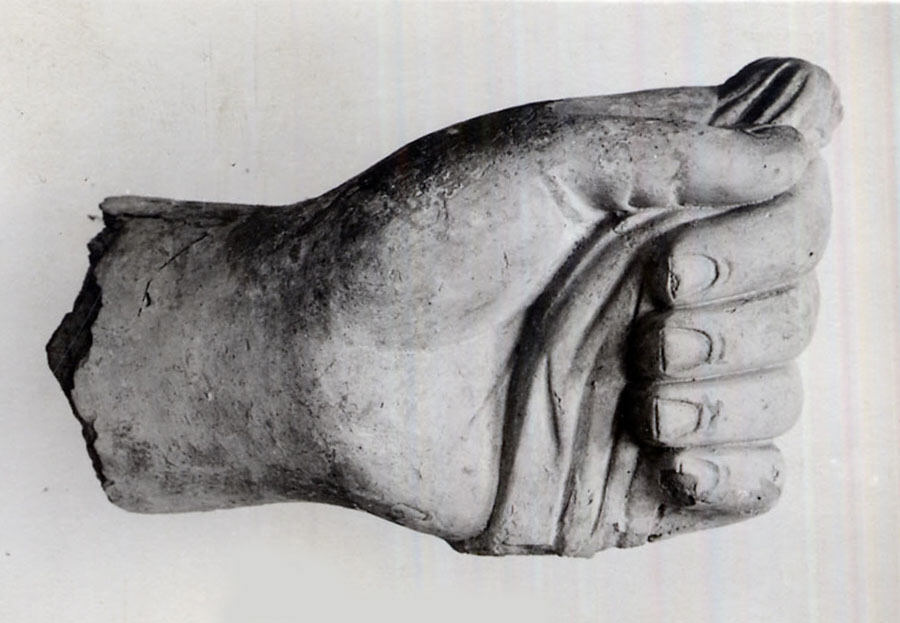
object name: hand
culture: central asian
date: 201-700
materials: clay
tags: hands